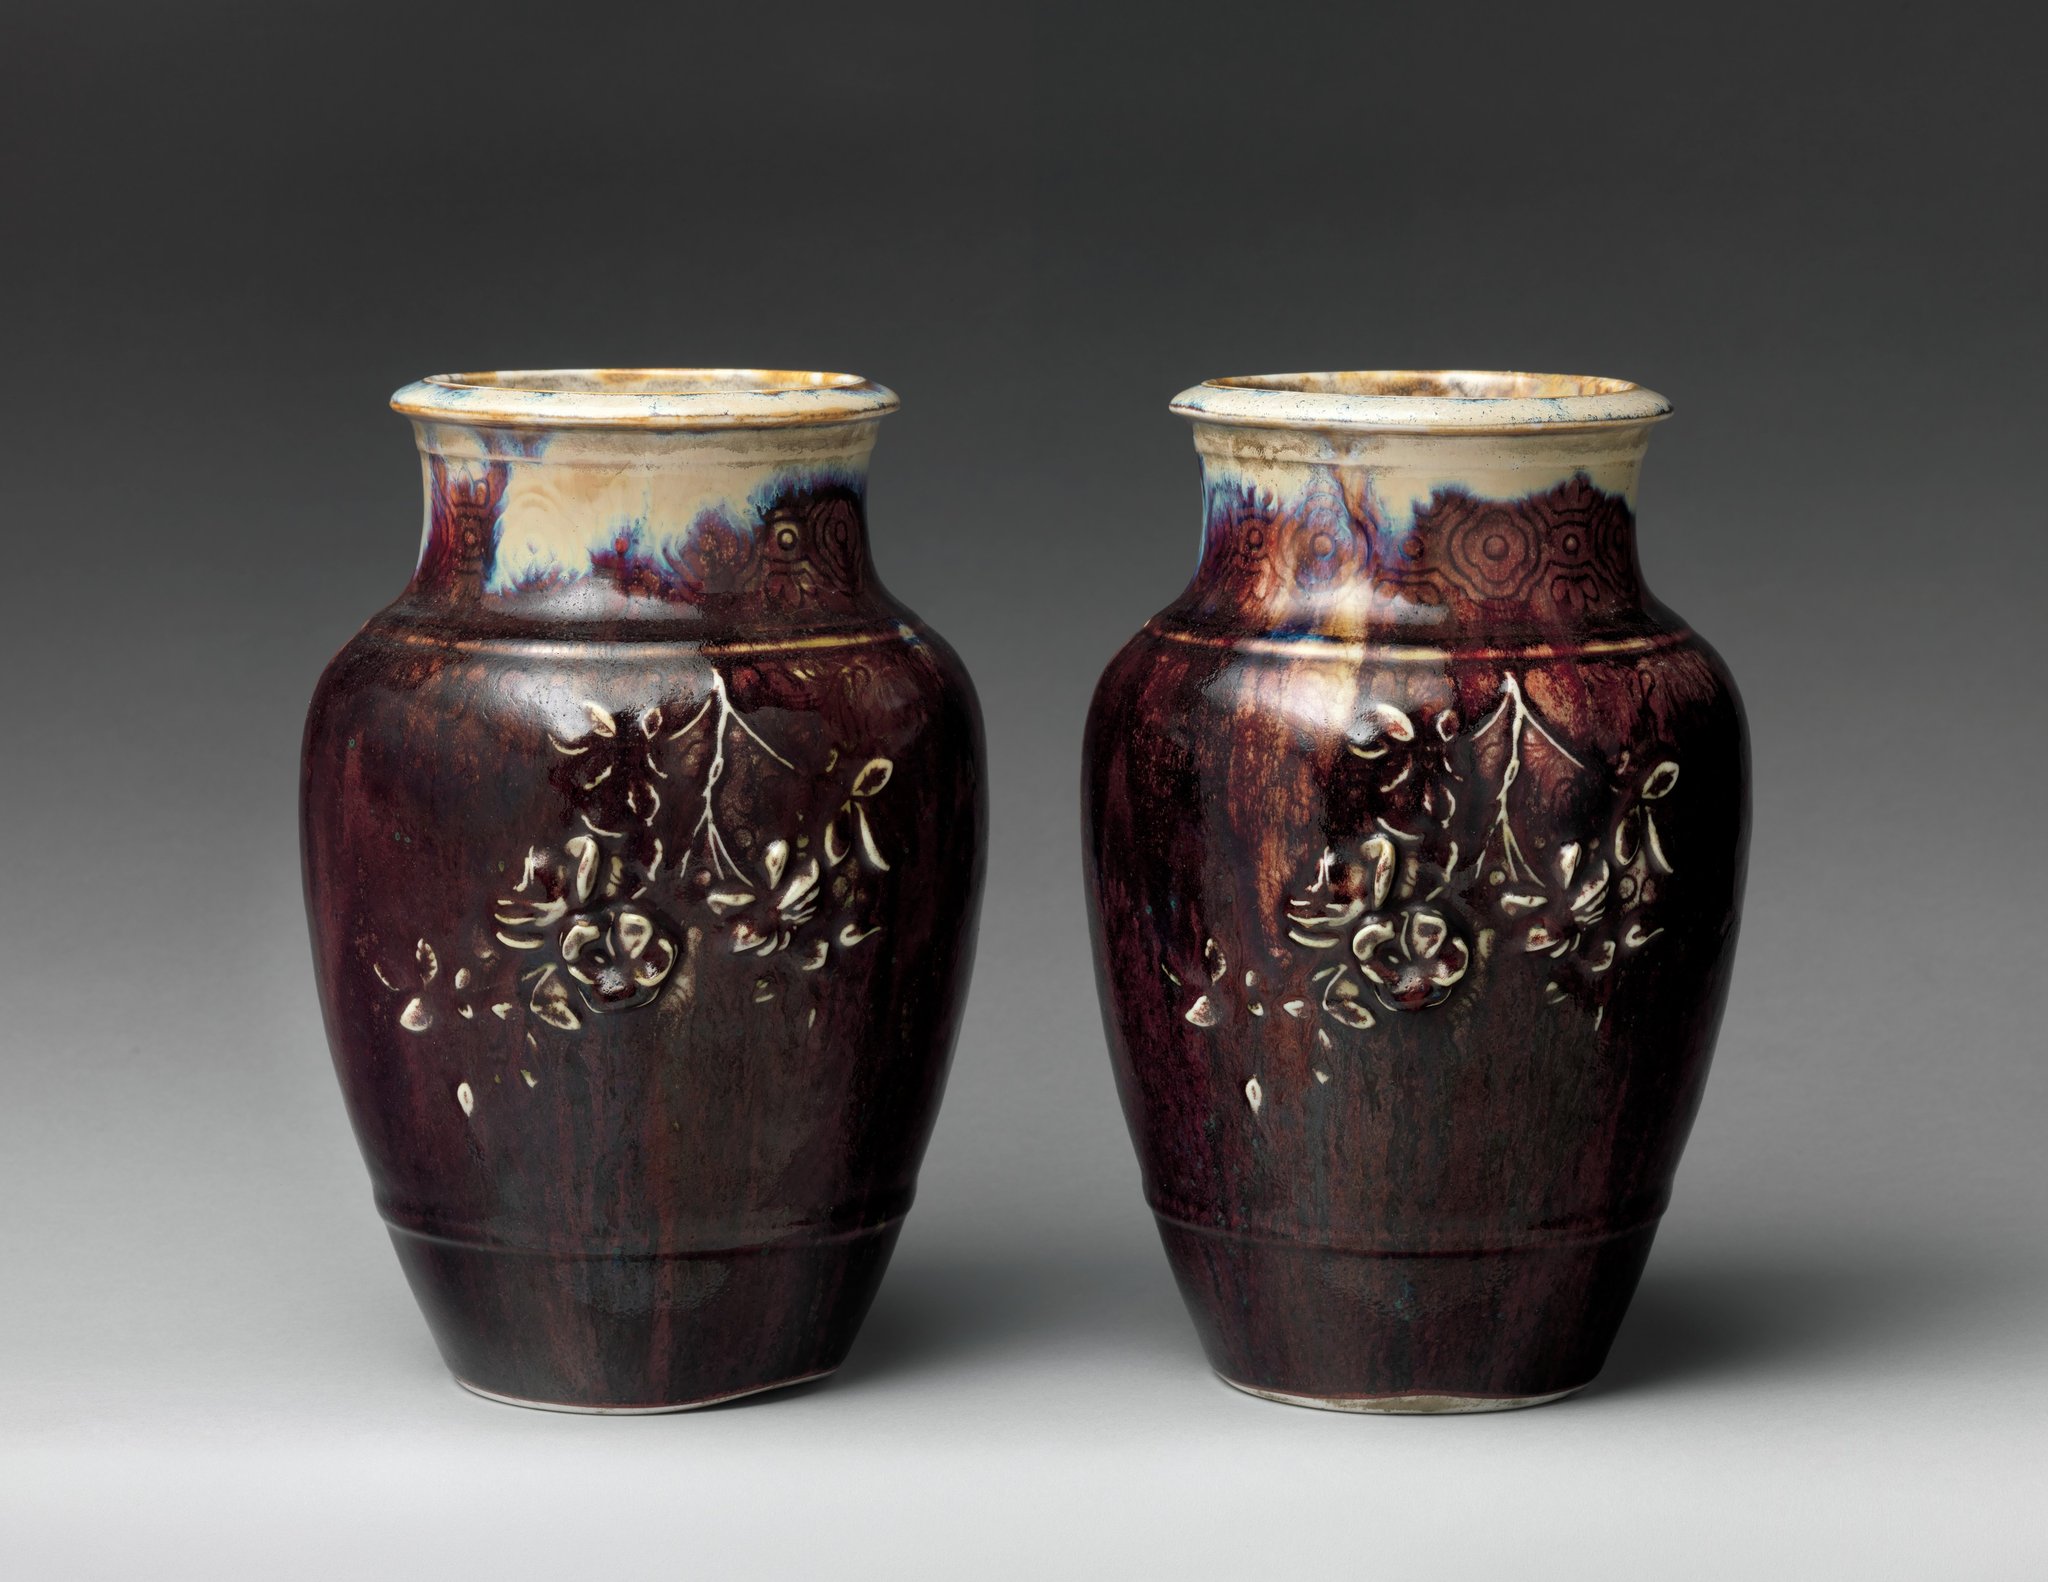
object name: vase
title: Pair of vases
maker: haviland & co.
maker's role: manufactory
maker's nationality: american and french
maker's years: 1864-1931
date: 1884-1886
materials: hard paste porcelain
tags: flowers